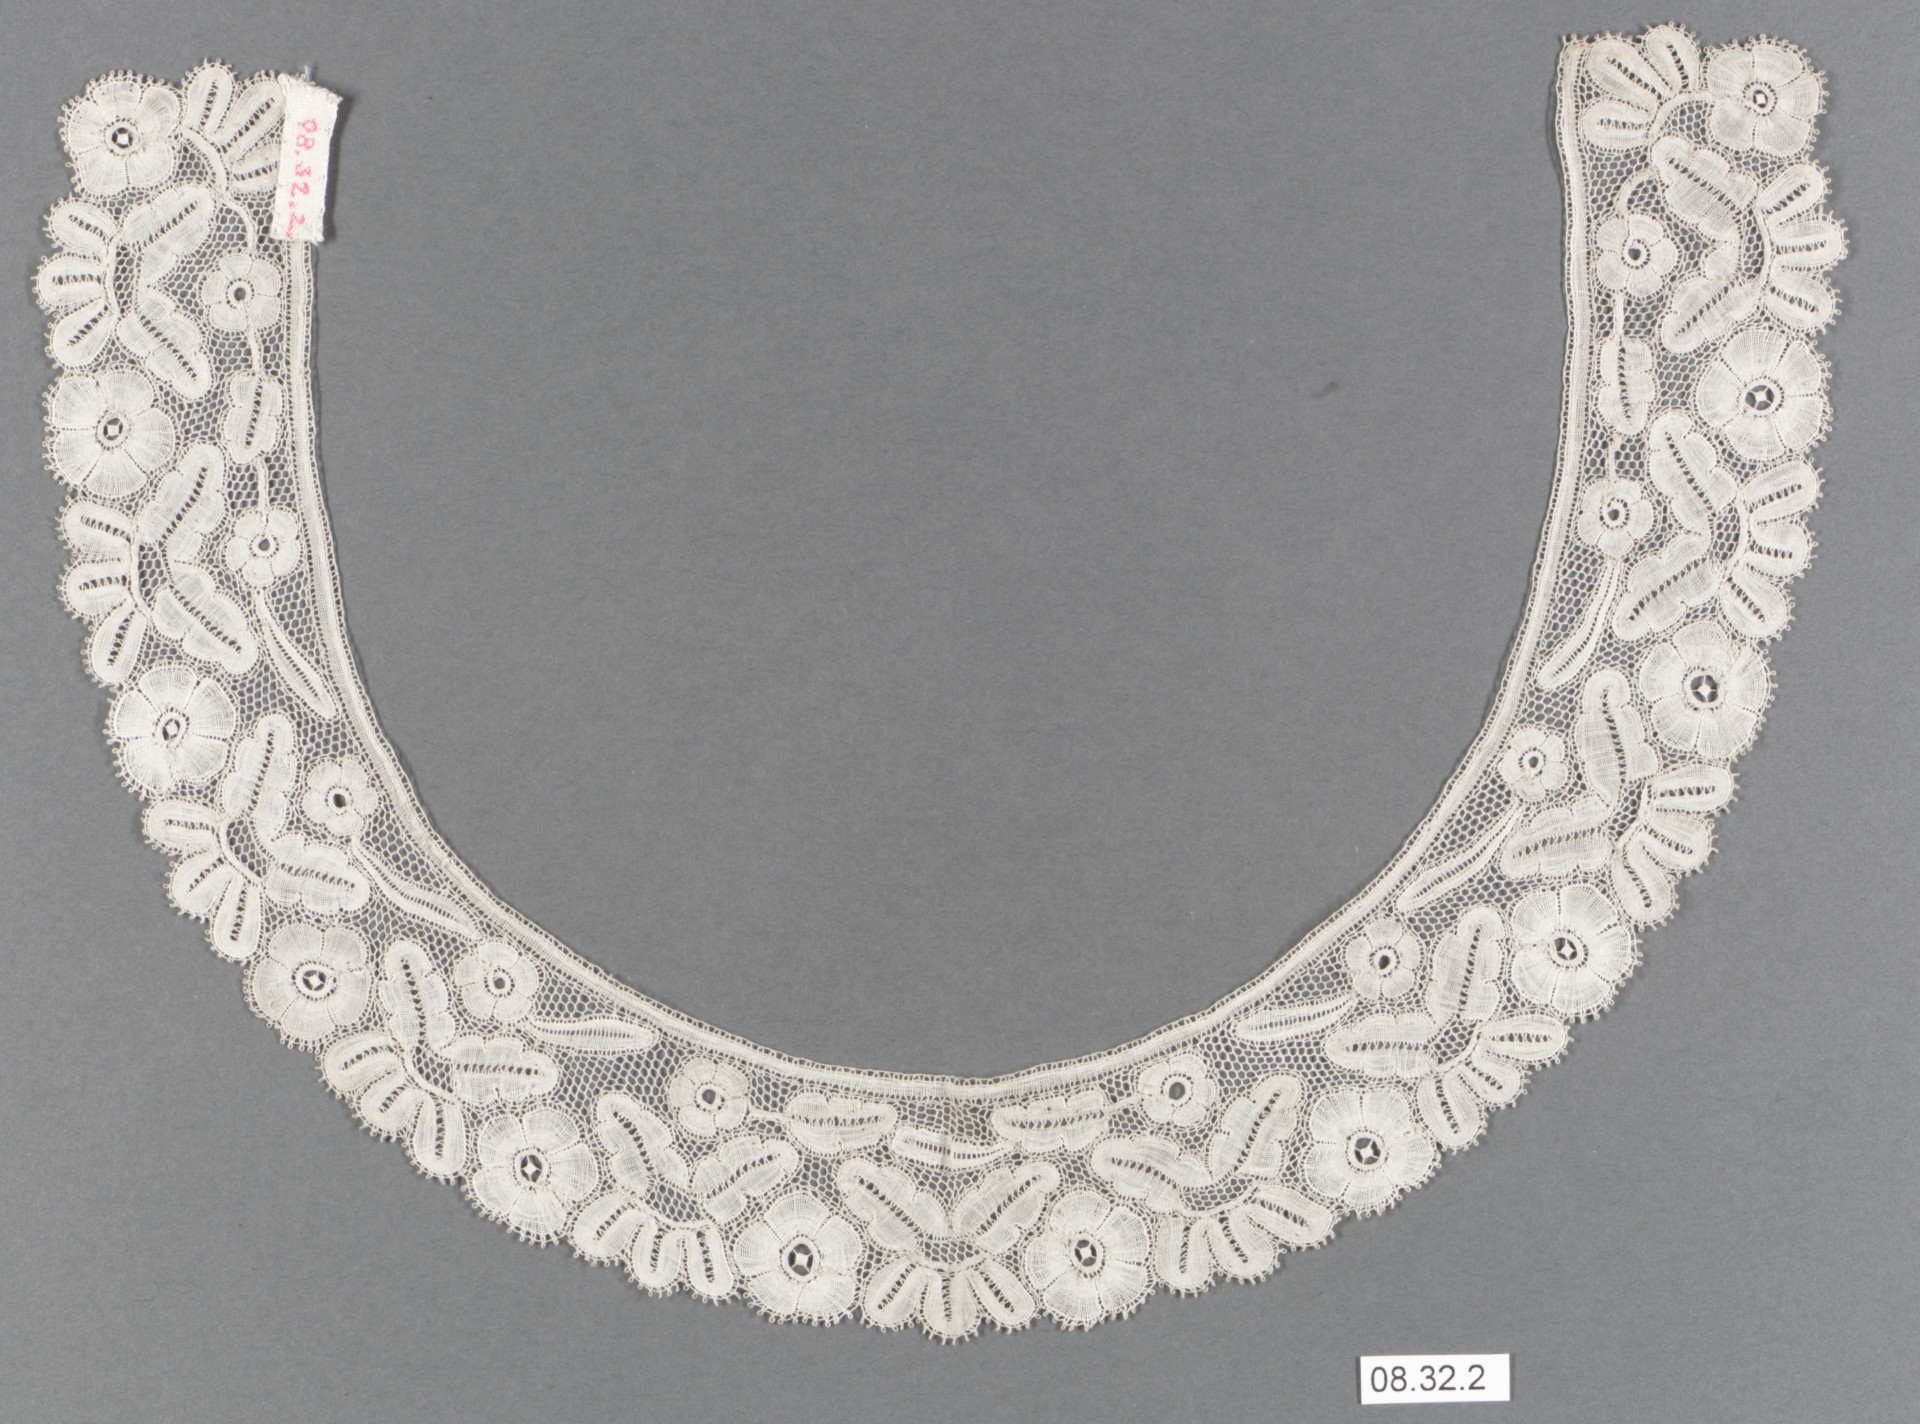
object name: collar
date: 1801-1900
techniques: lace